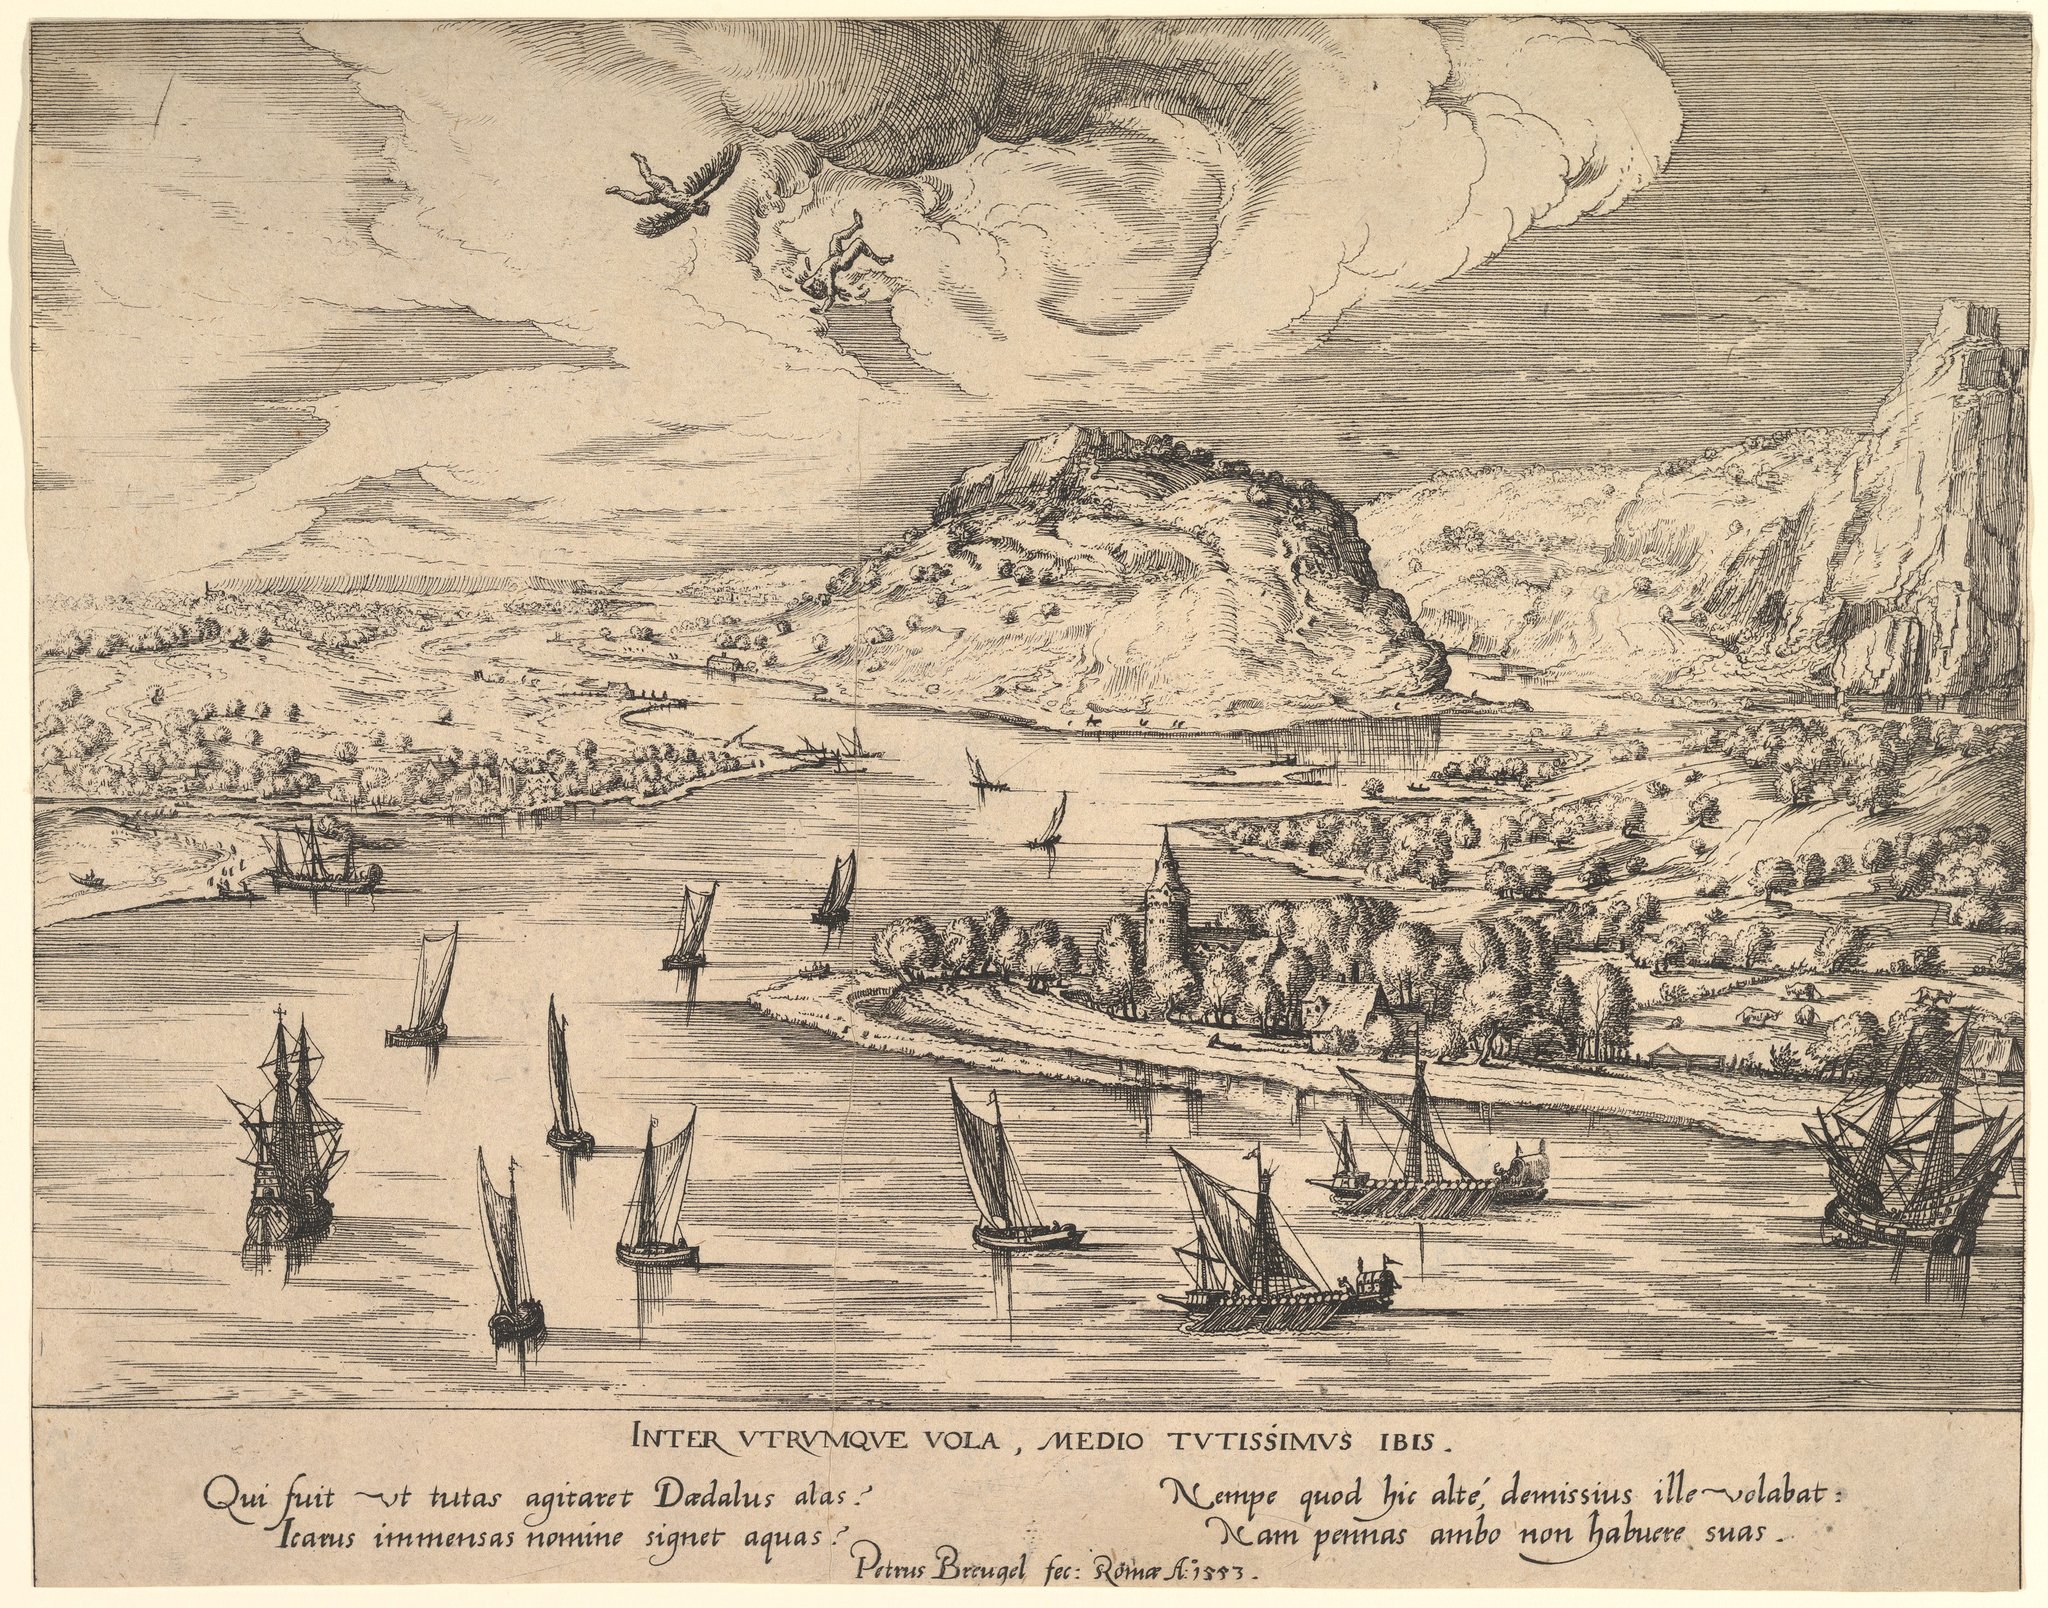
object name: print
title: River Landscape with Daedalus and Icarus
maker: simon novellanus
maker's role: artist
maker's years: 16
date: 1595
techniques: etching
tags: rivers,landscapes,boats